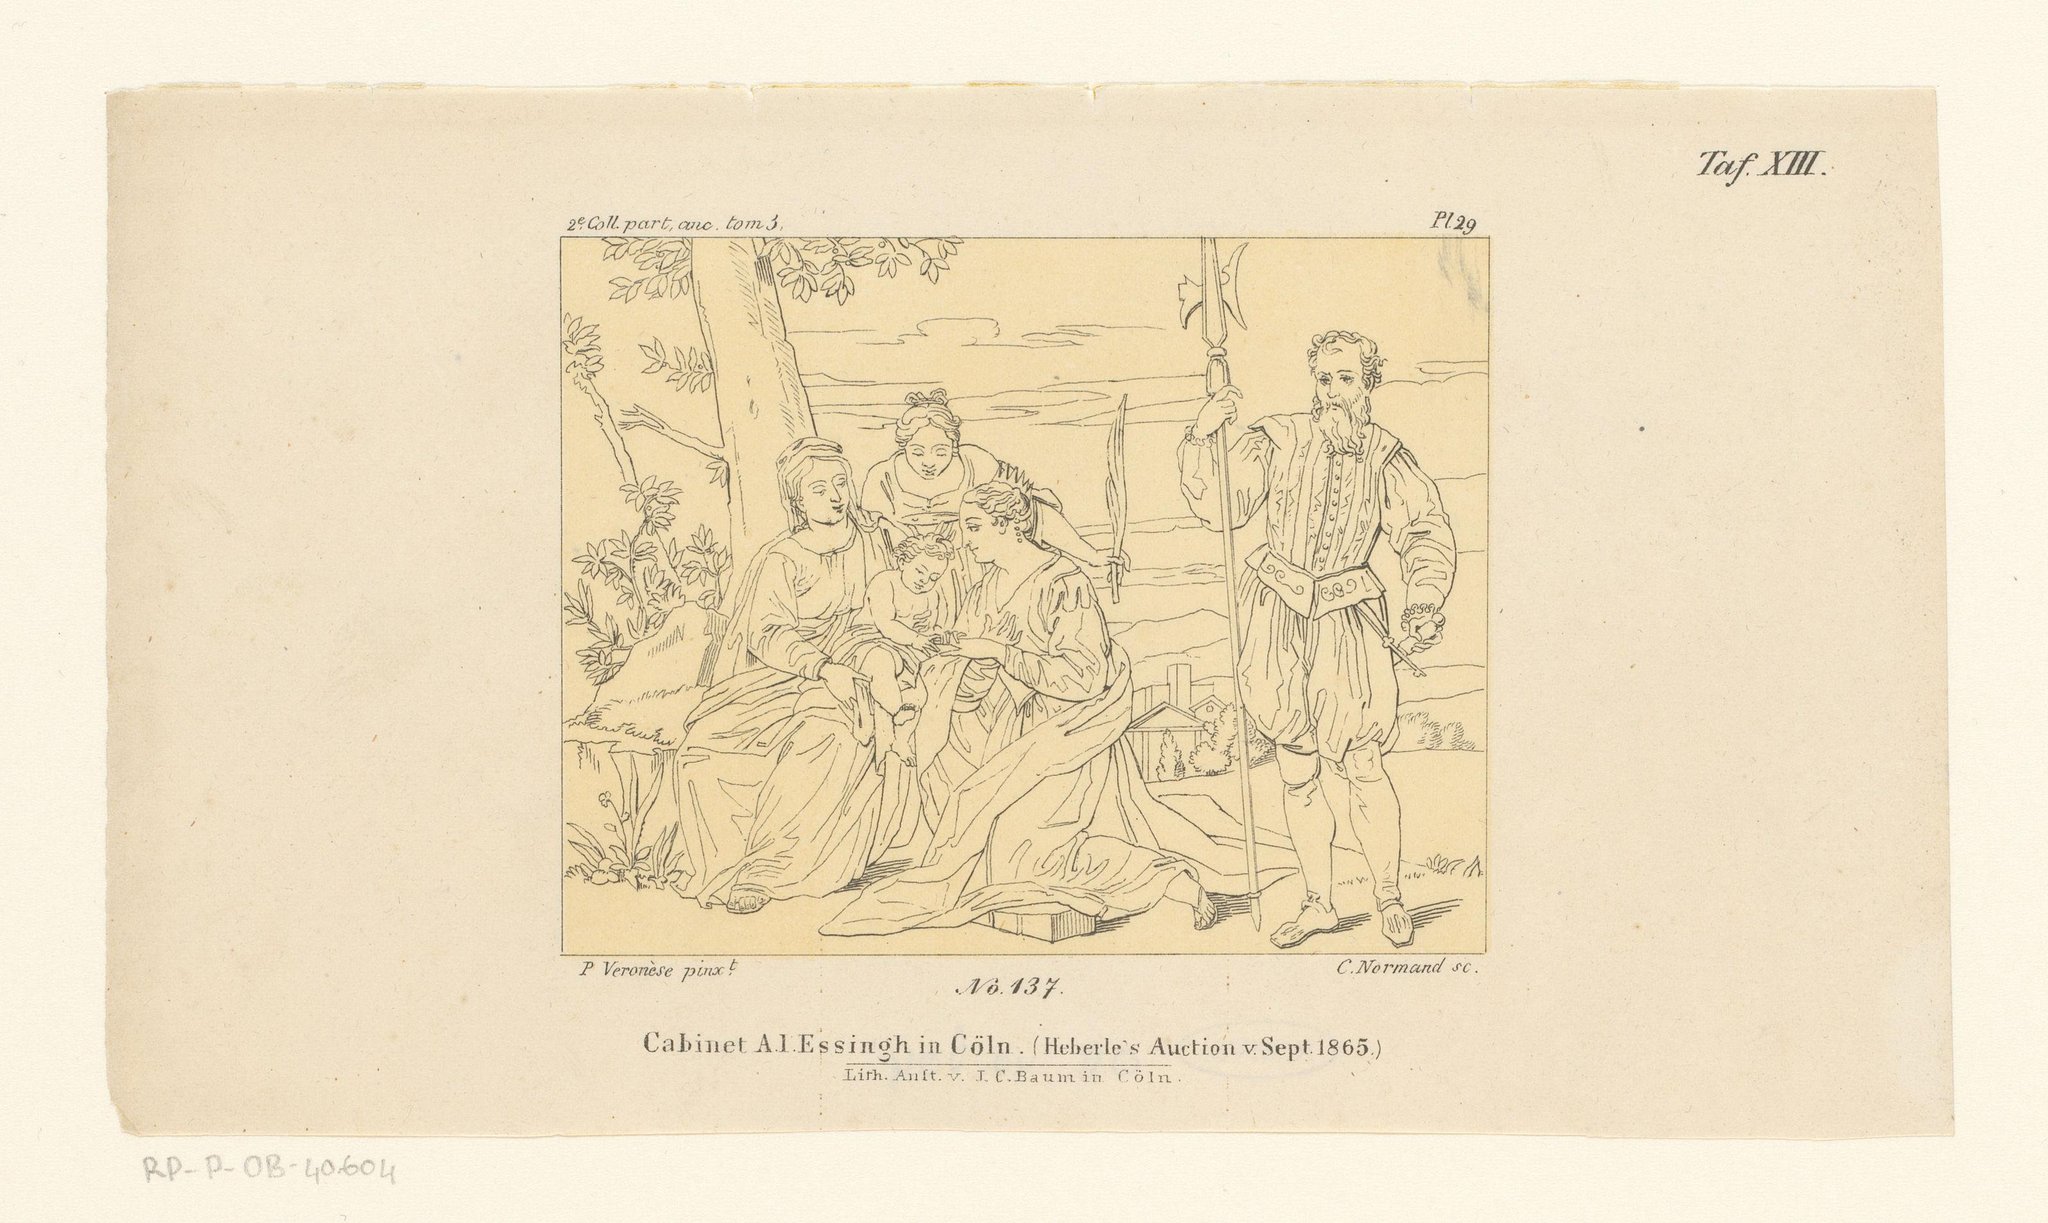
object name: print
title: Mariage de St. Catherine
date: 1865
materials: paper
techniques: tone lithography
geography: cologne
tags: madonna: i.e. mary with the christ-child, the virgin martyr lucy (lucia) of syracuse; possible attributes: dagger or sword (in neck), eyes, flames at feet, lamp, ox, the mystic marriage of st. catherine of alexandria with the infant christ: the christ-child puts a ring on her finger, christ-child together with others, the warrior martyr george (georgius); possible attributes: banner (red cross on white field), (red) cross, dragon, (white) horse, broken lance, shield (with cross), sword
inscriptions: collector's mark: Lugt 2228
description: Prent verschenen in: Catalogue illustré de la collection des objets d'art qui composent le cabinet de Mr. Antione Jos. Essingh. Keulen: Chr. Gehly, 1865, Pl. 29.